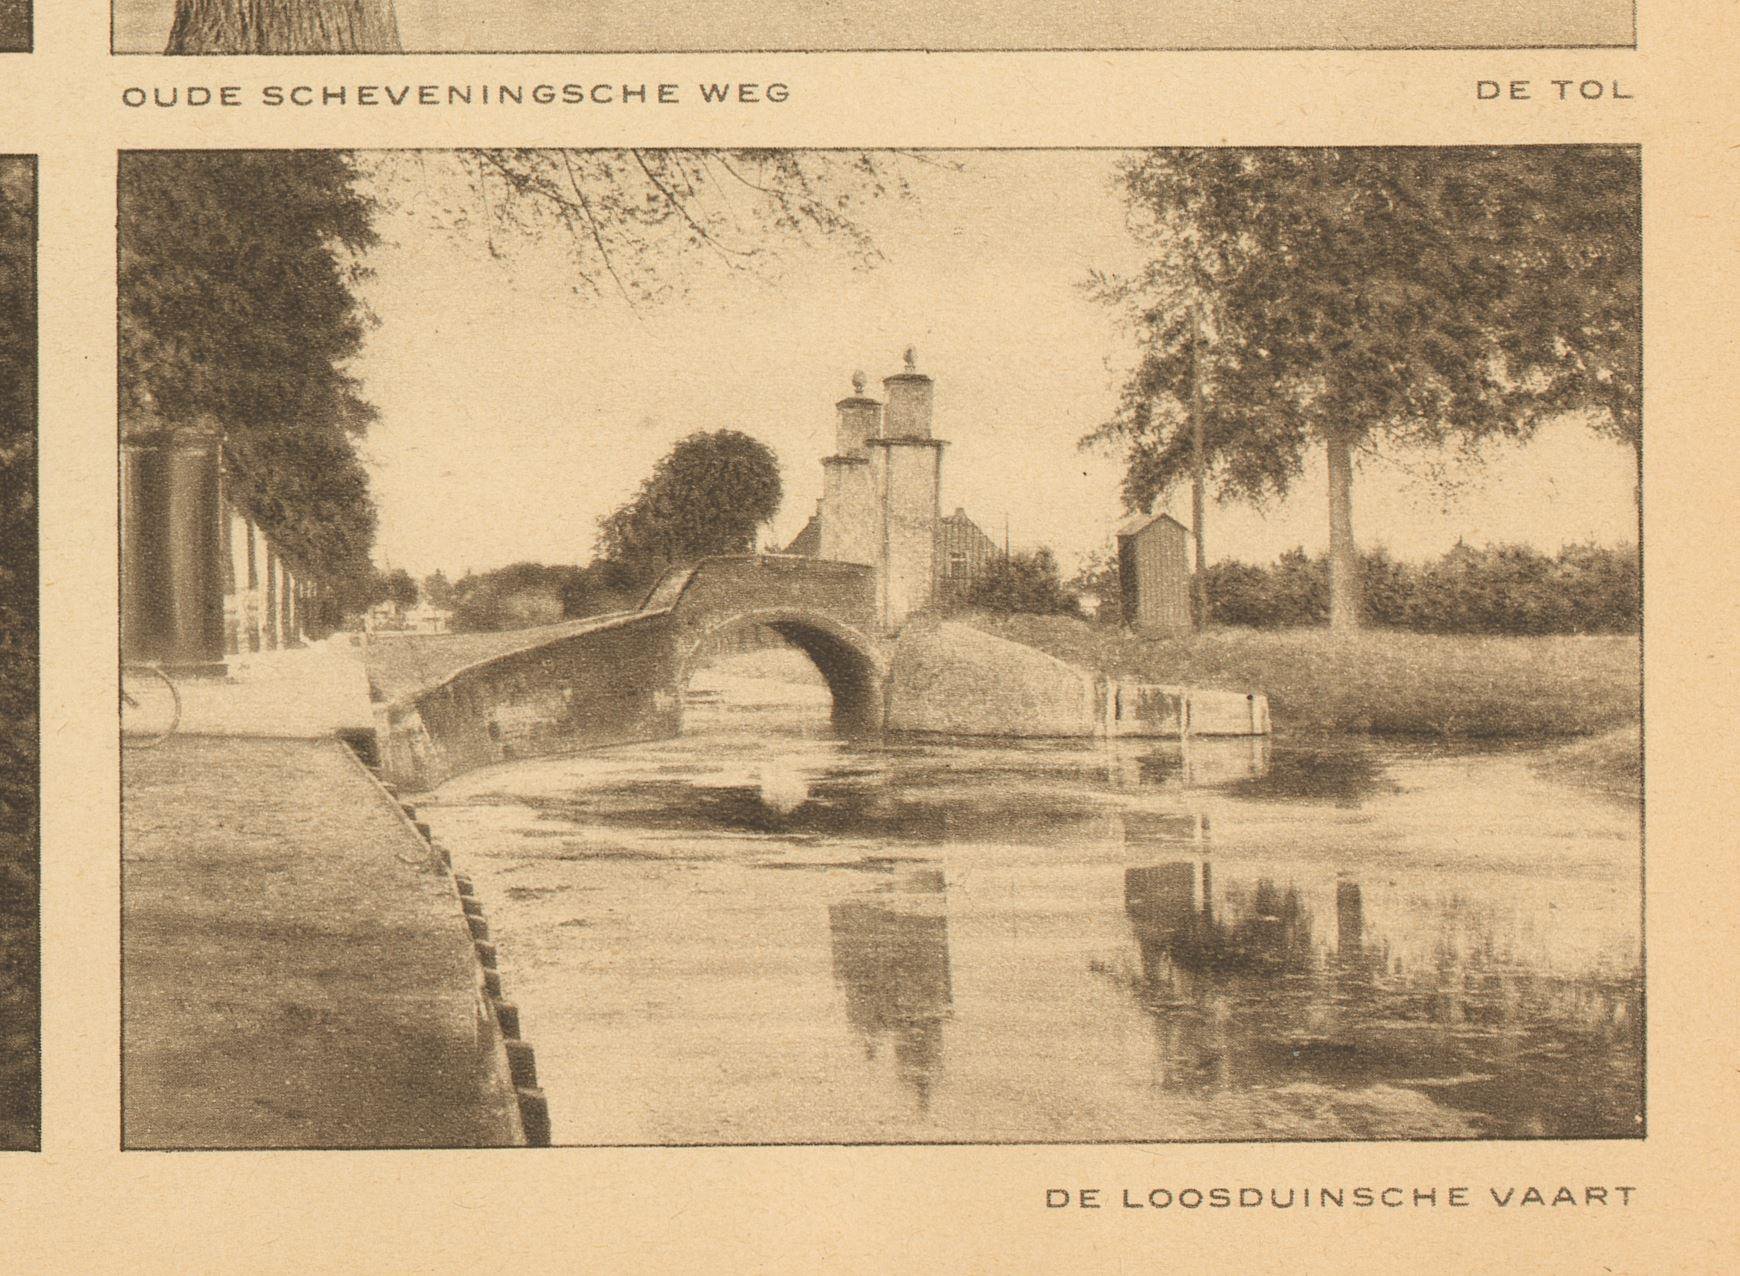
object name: photomechanical print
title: De Loosduinsche Vaart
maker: Anonymous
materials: paper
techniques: rotogravure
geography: leiden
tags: canal, bridge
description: Deze prent maakt deel uit van een album.